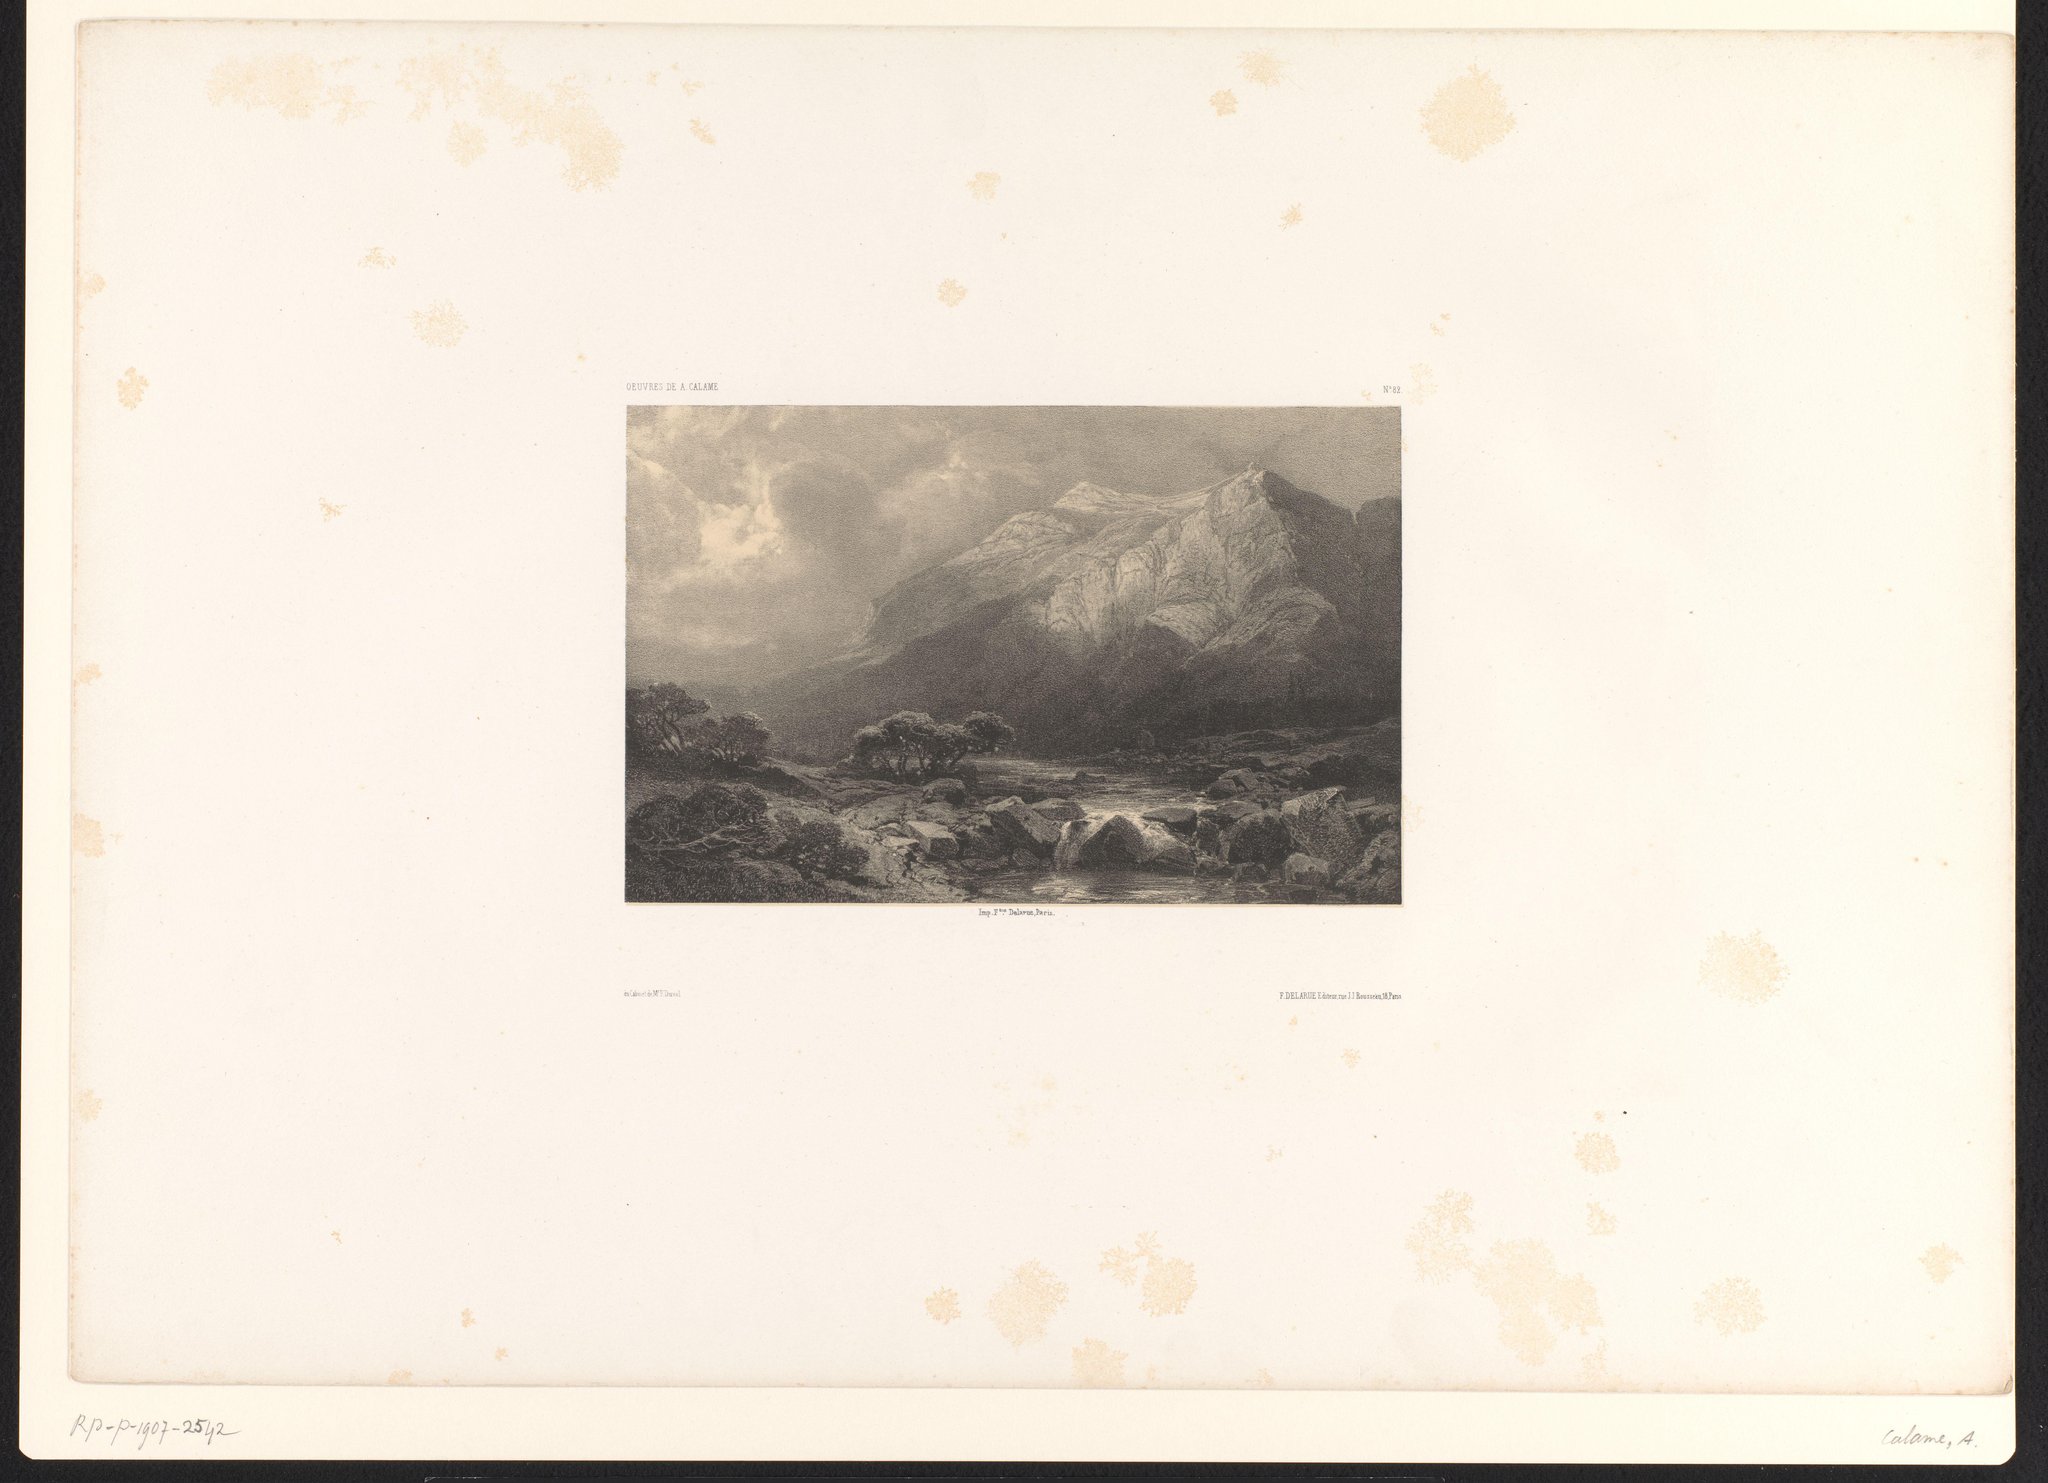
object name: print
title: Oeuvres de A. Calame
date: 1852-1855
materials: paper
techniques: lithograph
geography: paris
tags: brook, mountains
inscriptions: collector's mark: Lugt 2228a